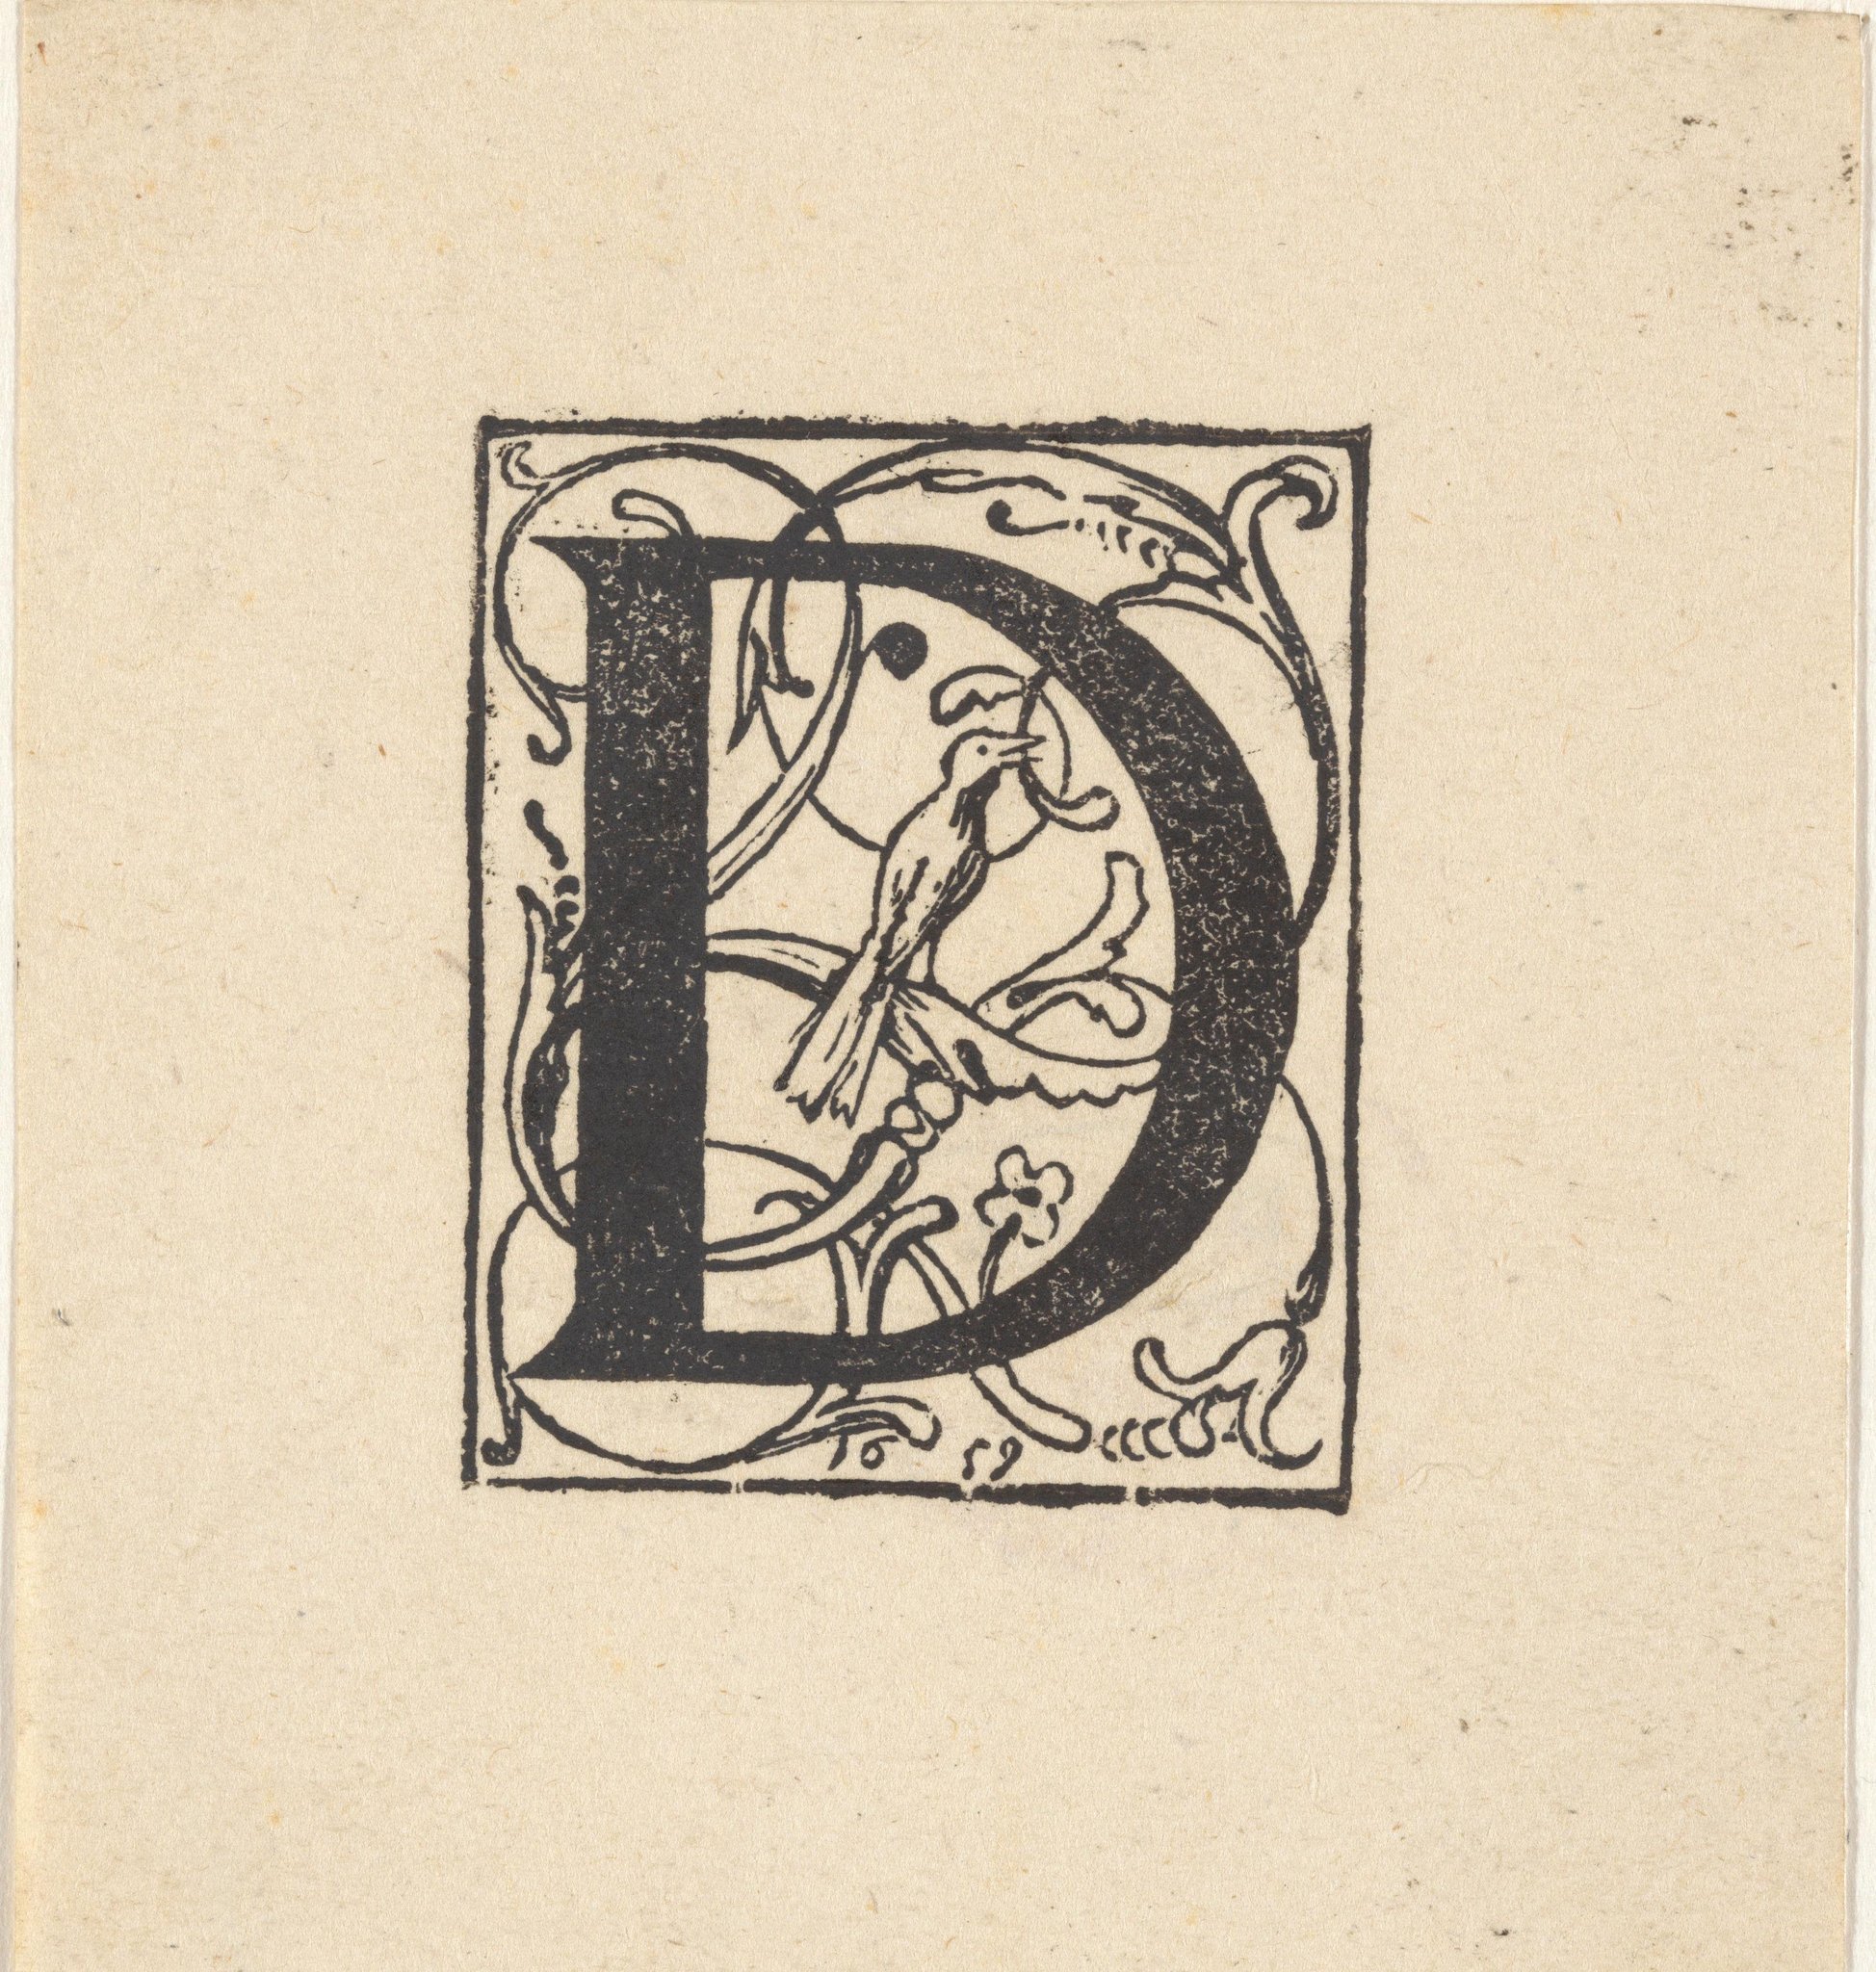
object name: print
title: Letter D in een omlijsting met een vogel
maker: Anonymous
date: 1600-1699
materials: paper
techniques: woodcut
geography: netherlands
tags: birds, fancy letters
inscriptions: collector's mark: Lugt 240, collector's mark: Lugt 698